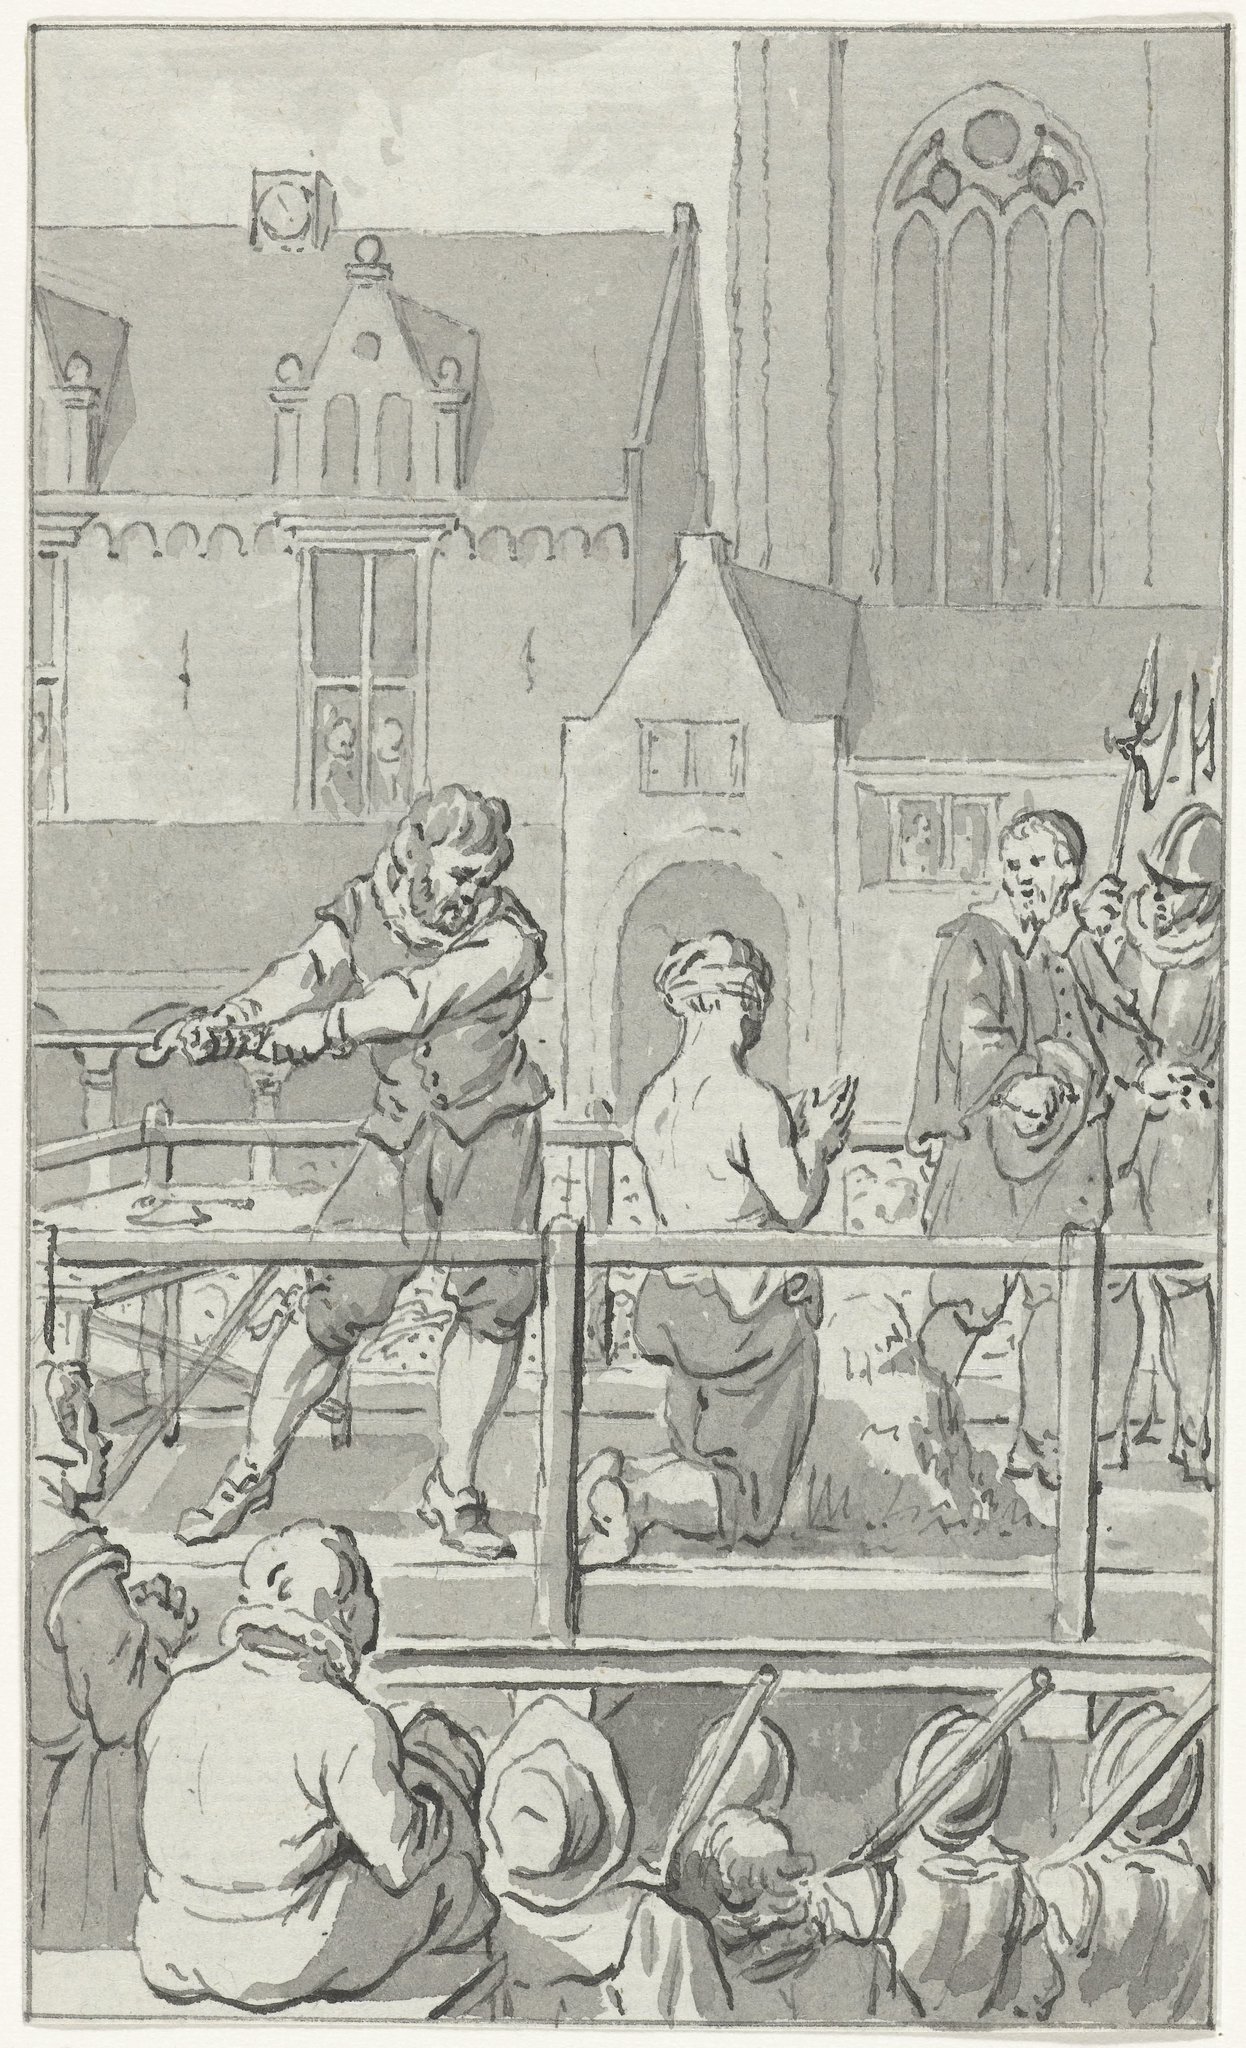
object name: drawing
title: Onthoofding van de graveur Cornelis de Hooghe, 1583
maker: jacobus buys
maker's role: draughtsman, print maker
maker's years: 1724-1801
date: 1787-1789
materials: ink, paper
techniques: brush, pen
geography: netherlands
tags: the hague, print maker, cornelis de hooghe, historical persons, on the scaffold or place of execution, violent death by beheading, historical events and situations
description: Onthoofding van de Leidse graveur Cornelis de Hooghe, te Den Haag op 29 maart 1583. De man knielt met ontbloot bovenlichaam voor de beul op het schavot. De Hooghe werd veroordeeld wegens landverraad en onthoofd en gevierendeeld. Hij beweerde een bastaardzoon van keizer Karel V te zijn. Ontwerp voor een prent.